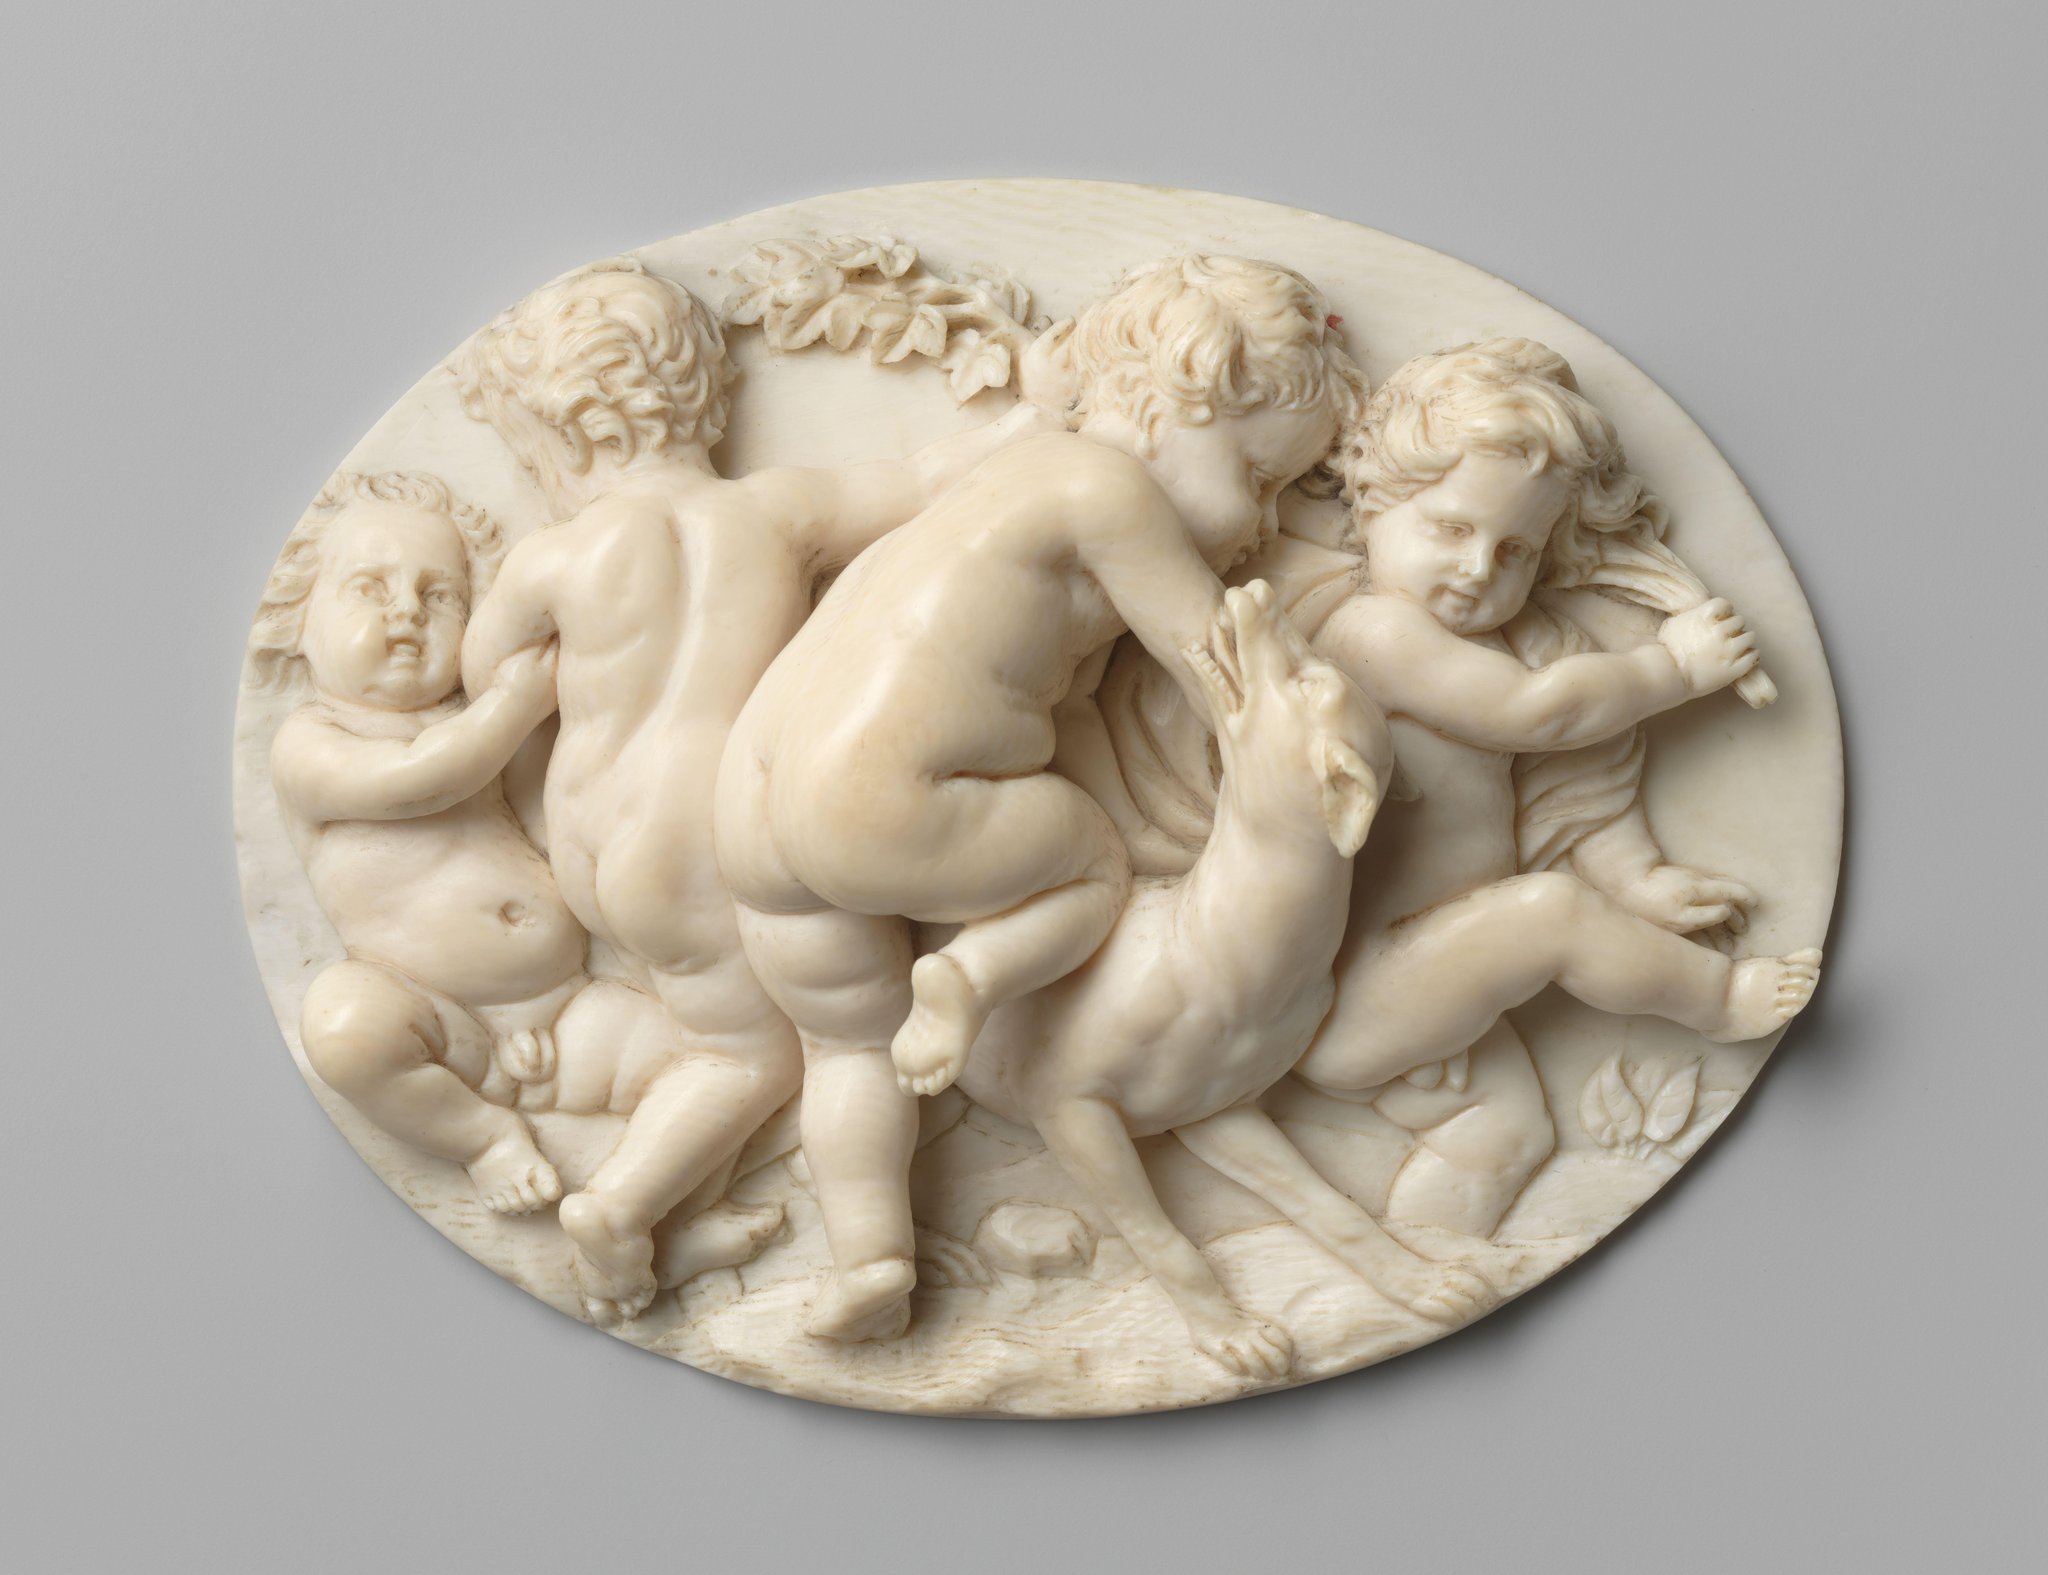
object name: relief sculpture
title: Putti in a Circle Dance with a Dog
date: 1700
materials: ivory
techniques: cutting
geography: dusseldorf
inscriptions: inscription, on the reverse, in pencil/ink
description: Ovaal reliëf van dansende putti, samen met een bijbehorend reliëf maken de putti een rondedans.